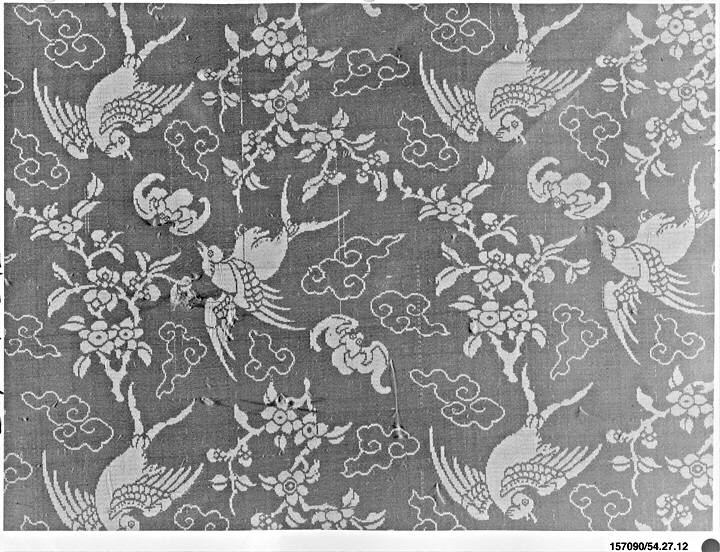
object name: length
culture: chinese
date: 1901-2000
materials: silk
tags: birds,flowers